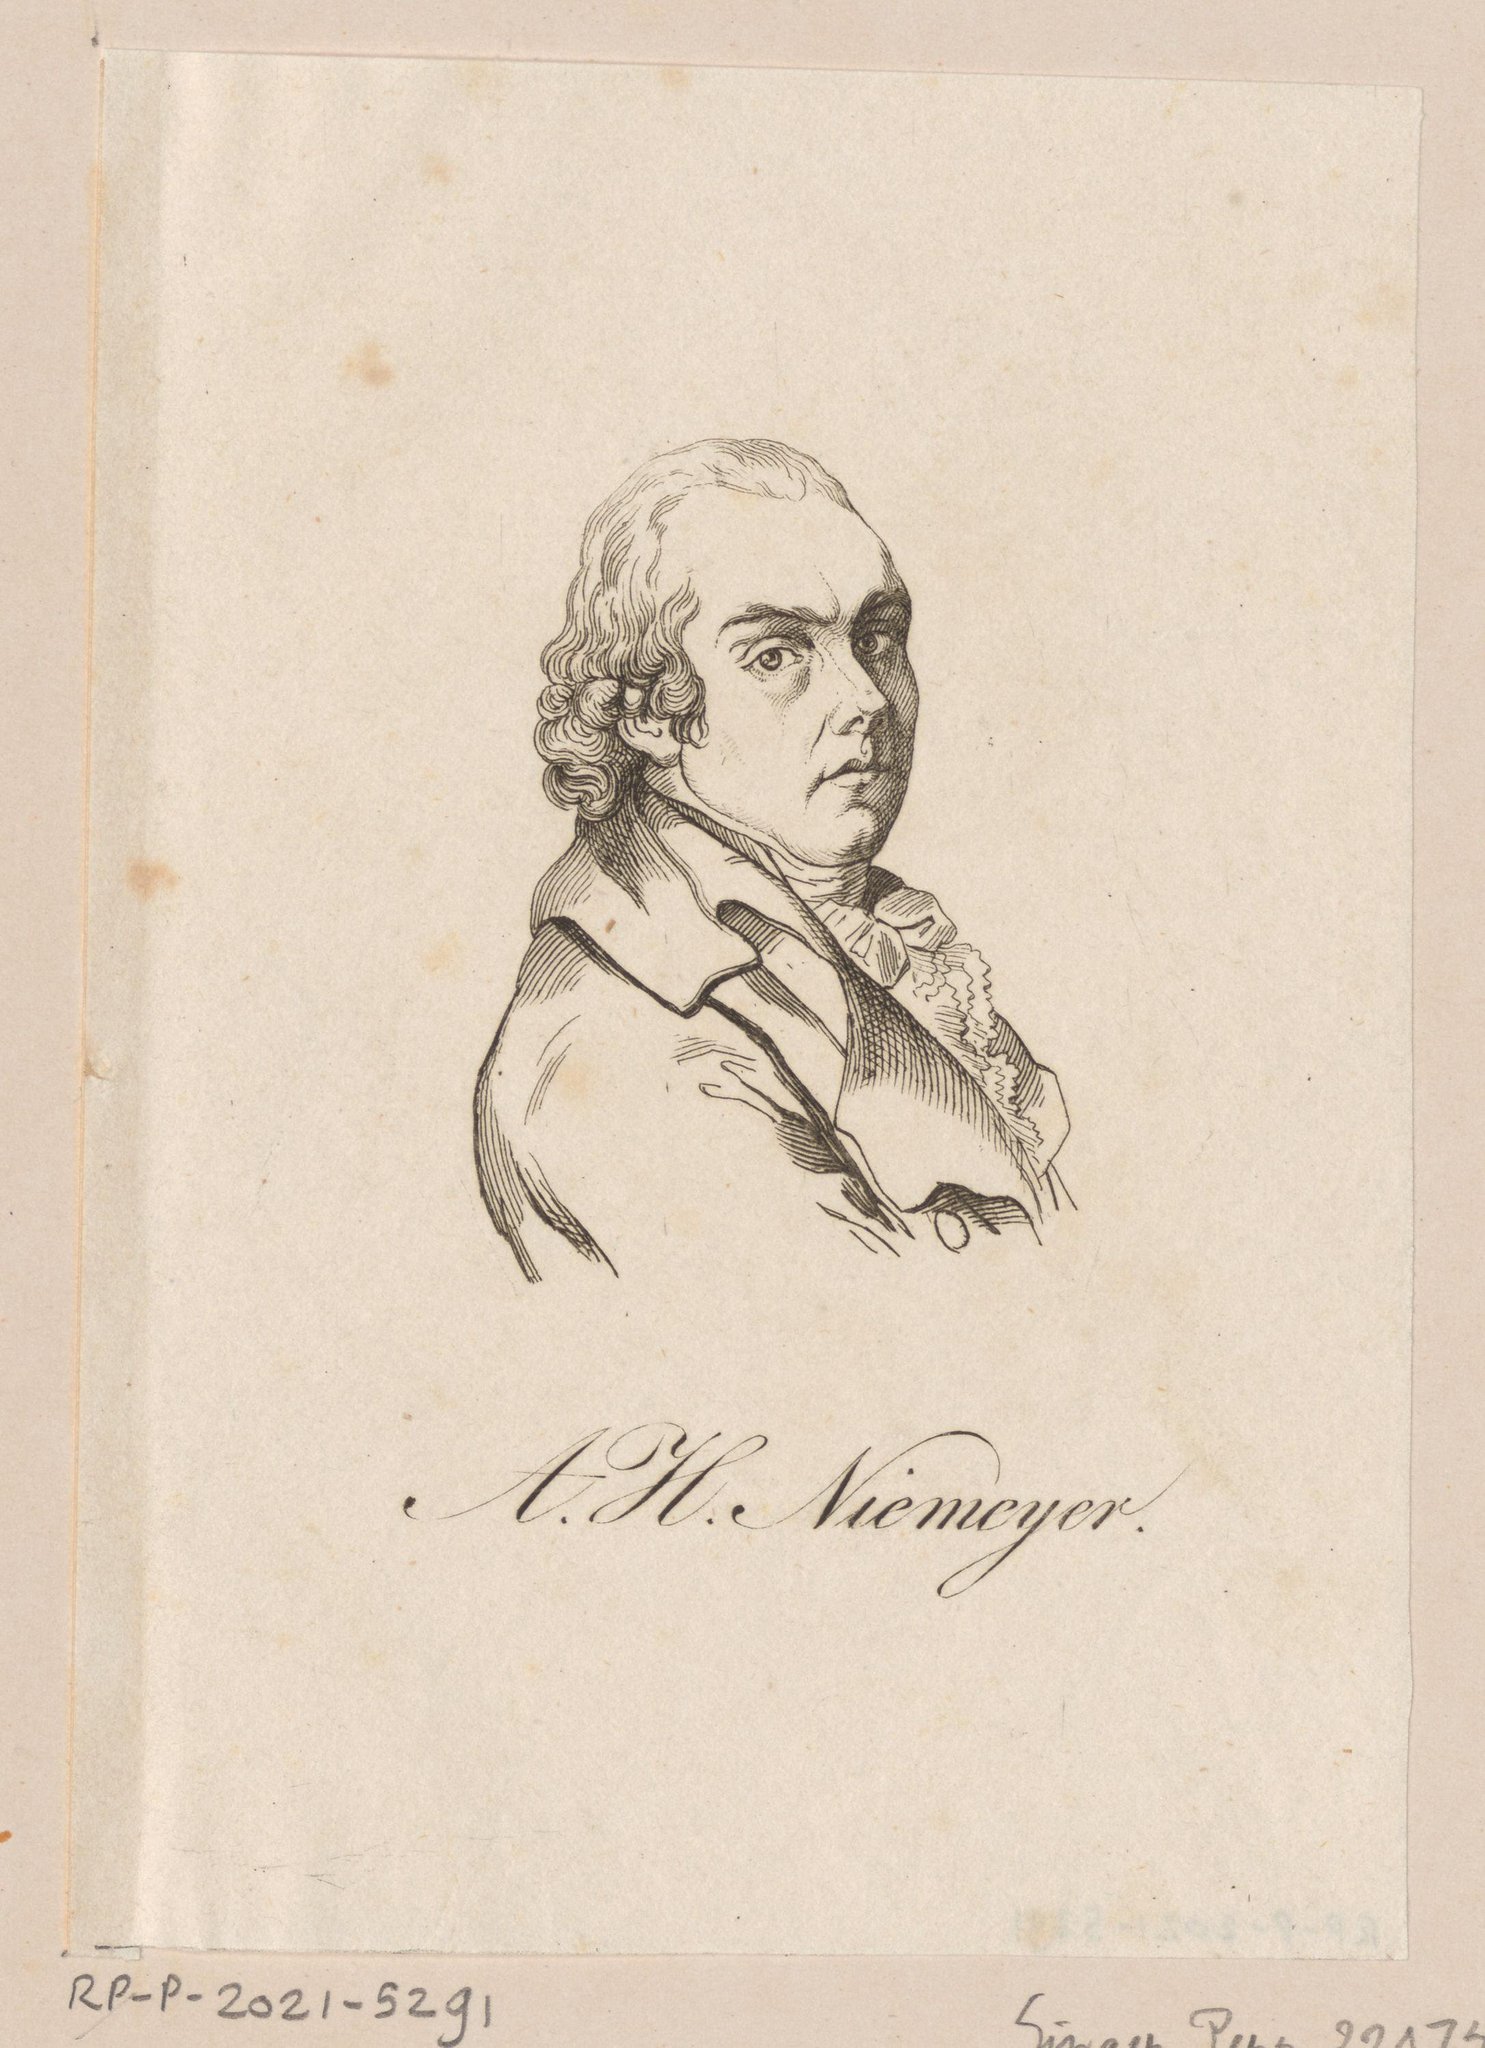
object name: print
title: Portret van August Hermann Niemeyer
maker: Anonymous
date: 1791-1849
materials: paper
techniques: etching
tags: theologian, historical persons